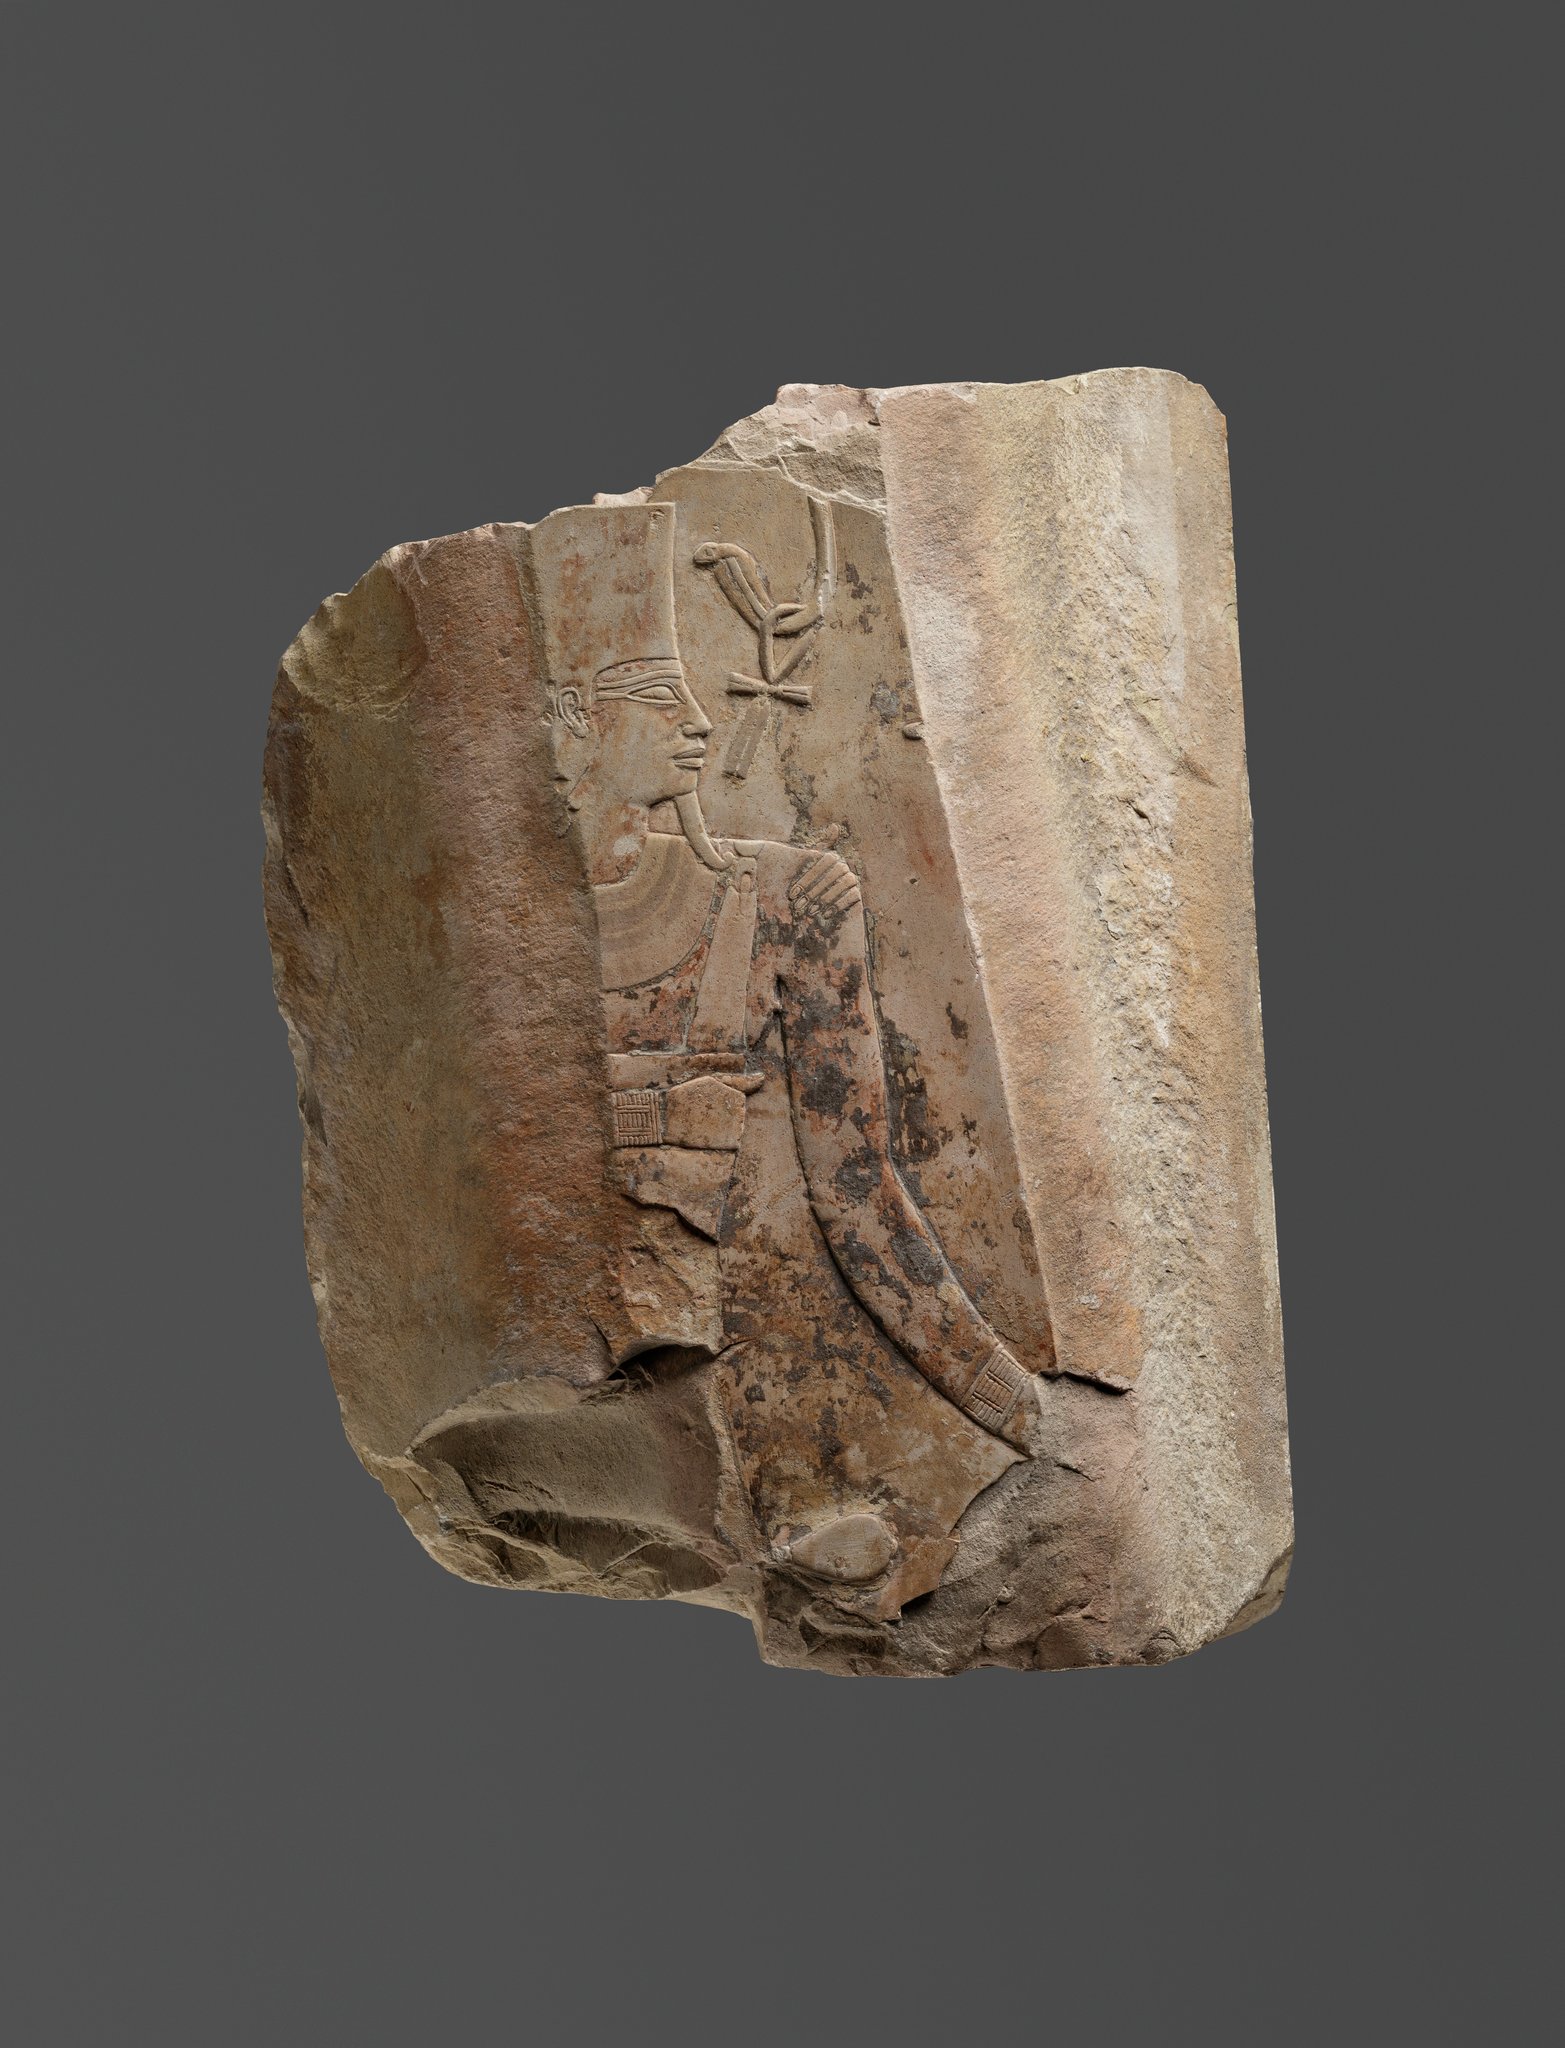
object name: relief, nebhepetre mentuhotep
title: Relief fragment of Nebhepetre Mentuhotep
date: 2020-2000 BCE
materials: limestone, paint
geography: egypt